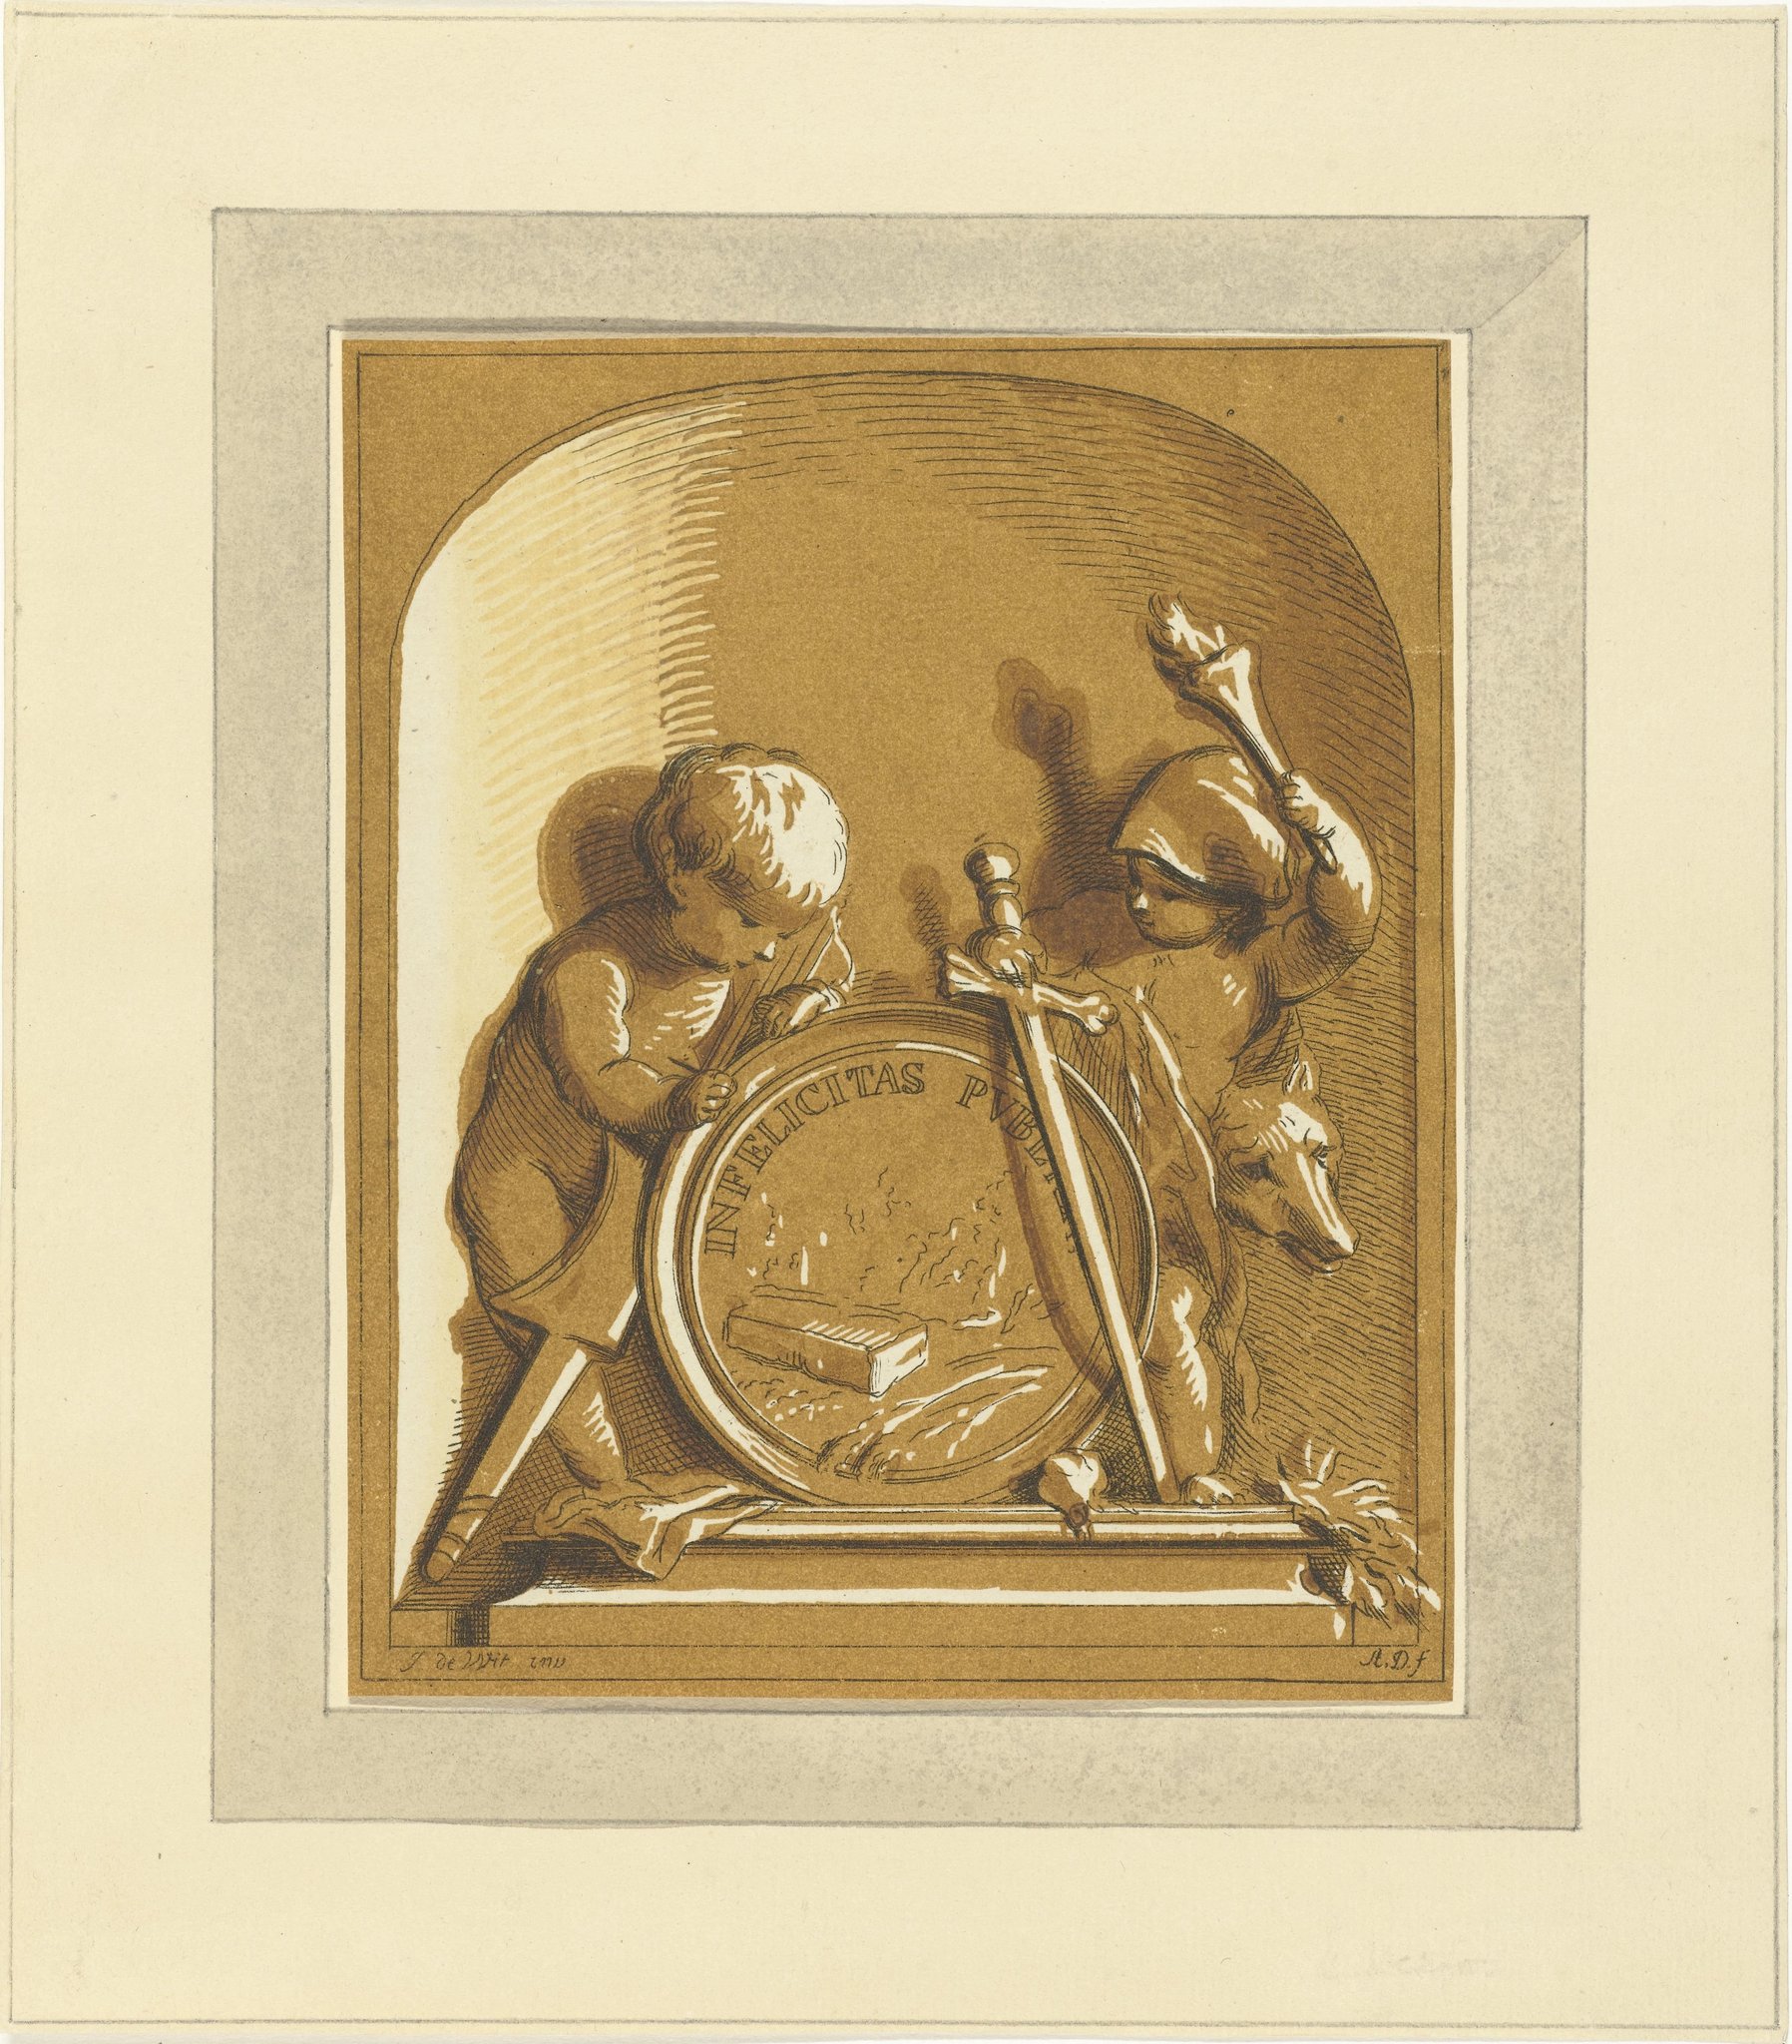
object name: print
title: Putti staand bij medaillon met graftombe, in nis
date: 1741-1820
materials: paper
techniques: etching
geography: leiden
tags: scenes symbolizing 'vanitas', grave, tomb, yoke, cupids: 'amores', 'amoretti', 'putti'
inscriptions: collector's mark: Lugt 2233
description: Twee putti met juk, zwaard, fakkel en wolf staan bij medaillon met voorstelling van landschap met graftombe en Latijnse inscriptie die verwijst naar tegenspoed. Zogenaamd witje in nis.